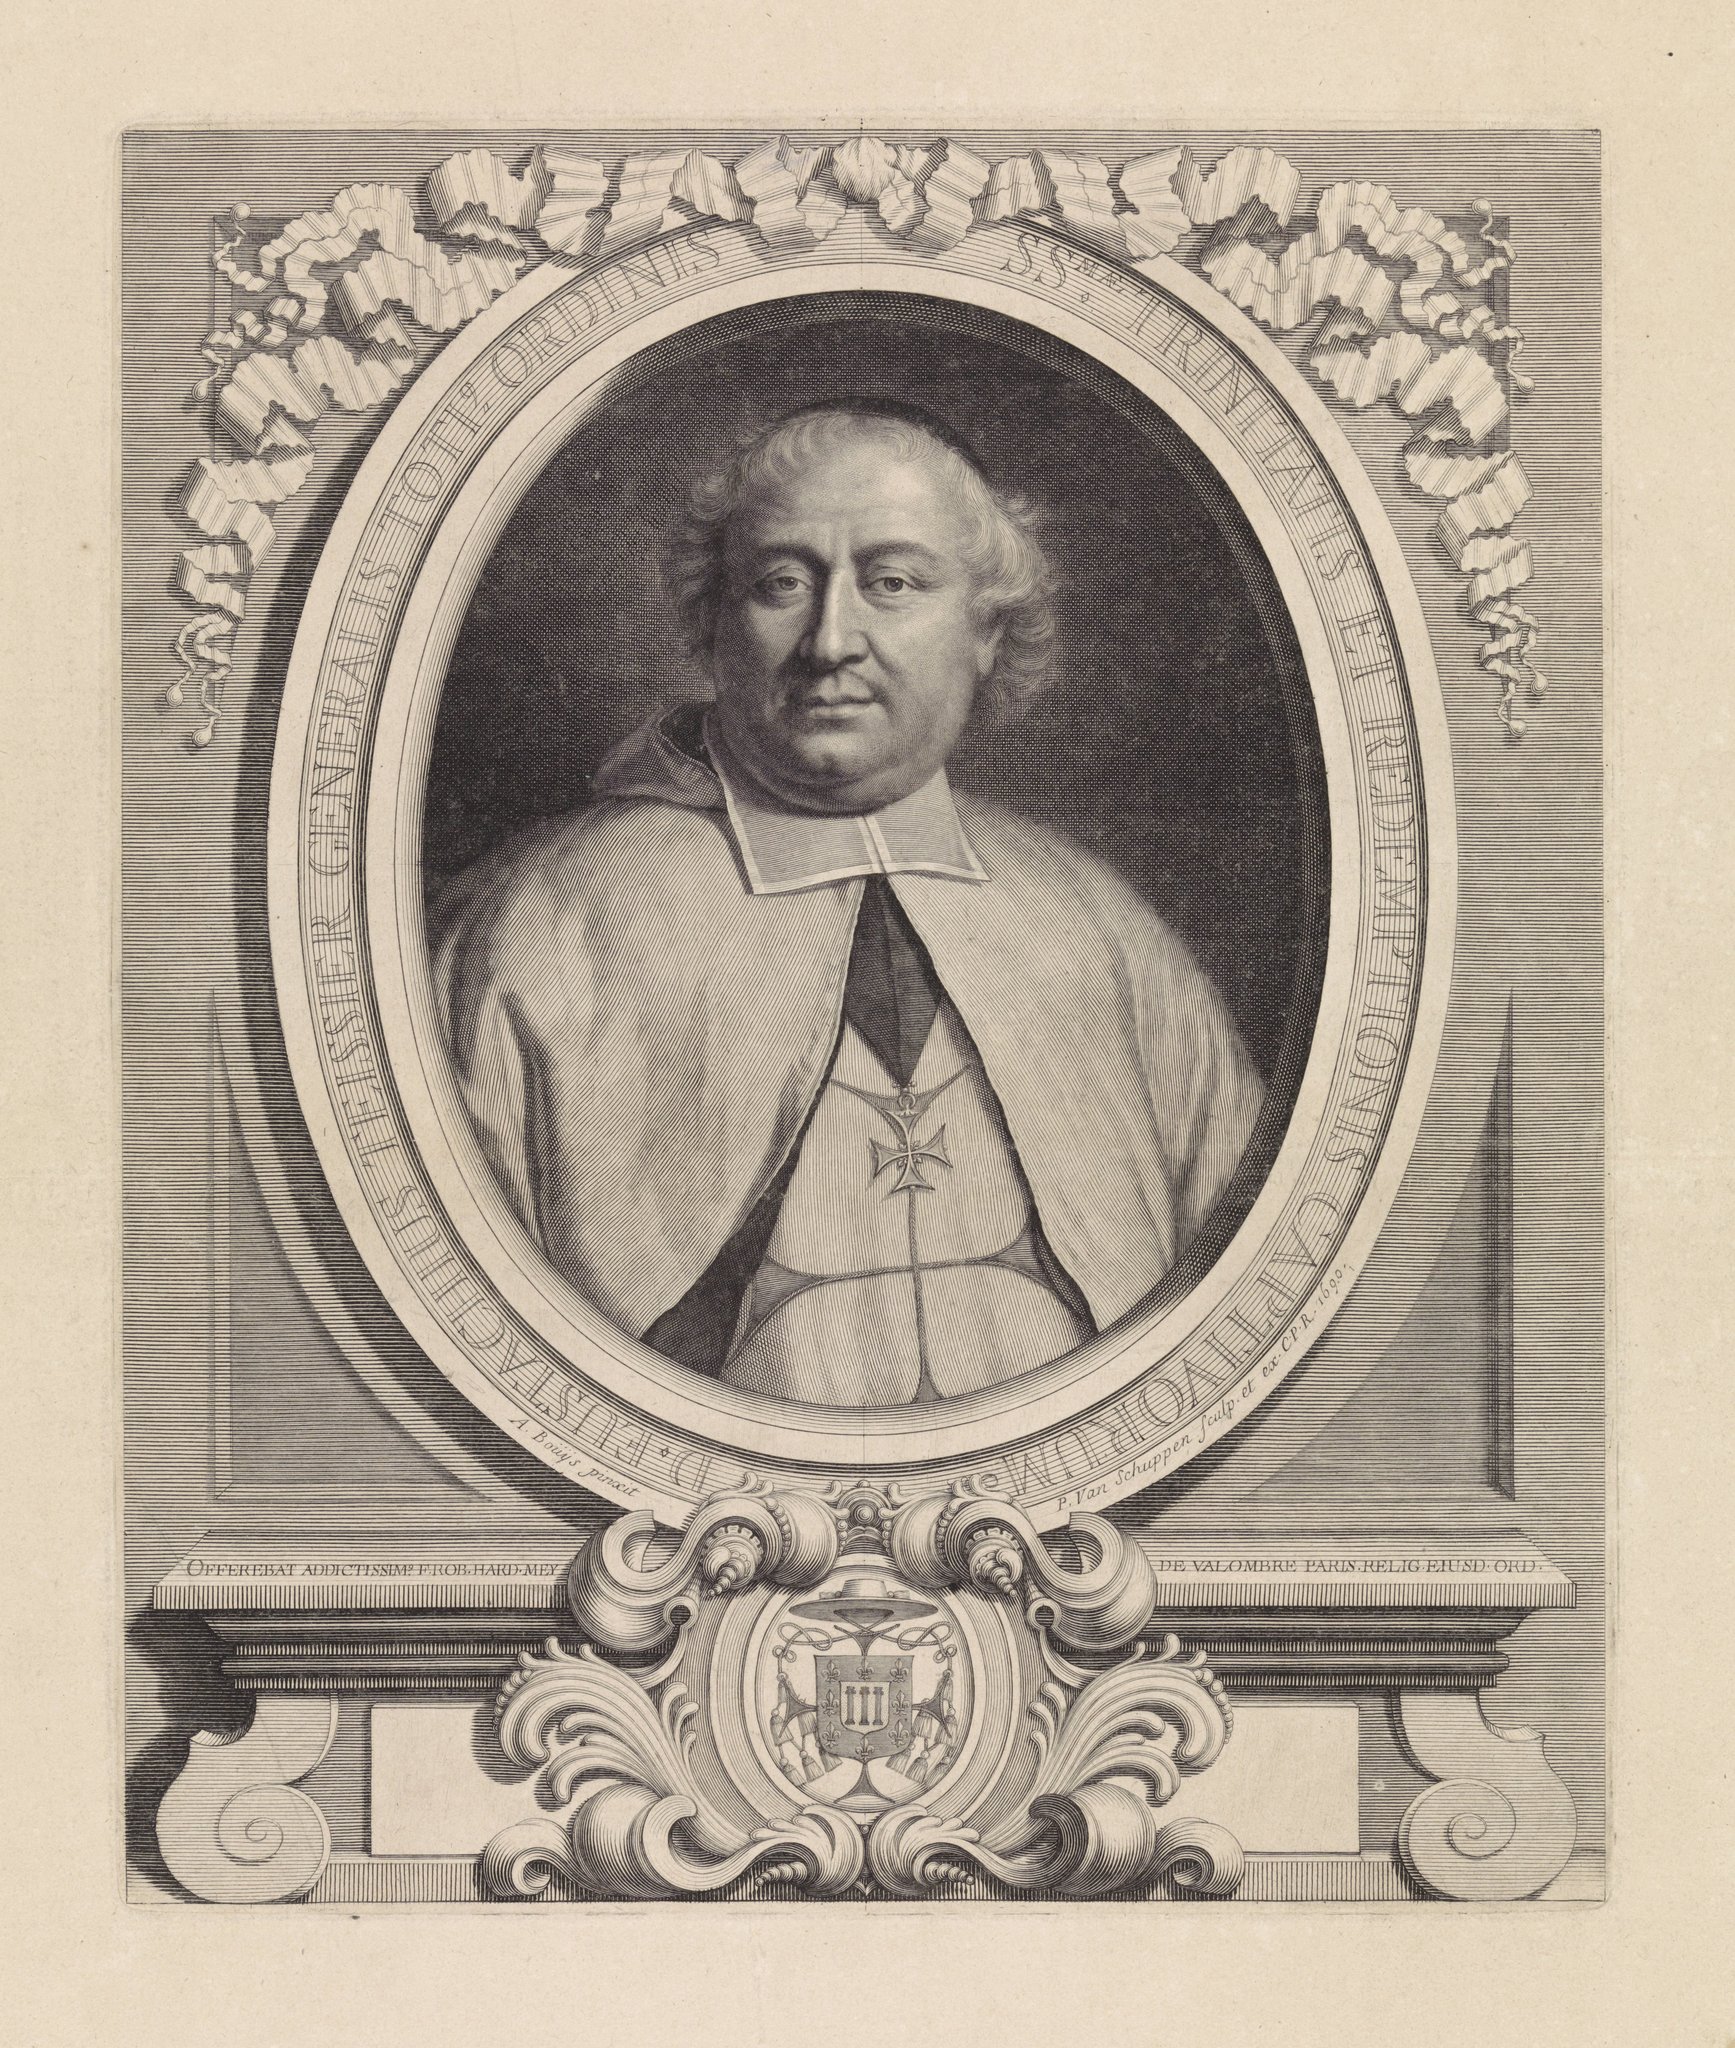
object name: print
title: Portret van Eustache Teissier, magister-generaal van de Orde der Trinitariërs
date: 1601-1690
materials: paper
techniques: engraving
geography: paris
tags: priest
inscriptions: collector's mark: Lugt 2228